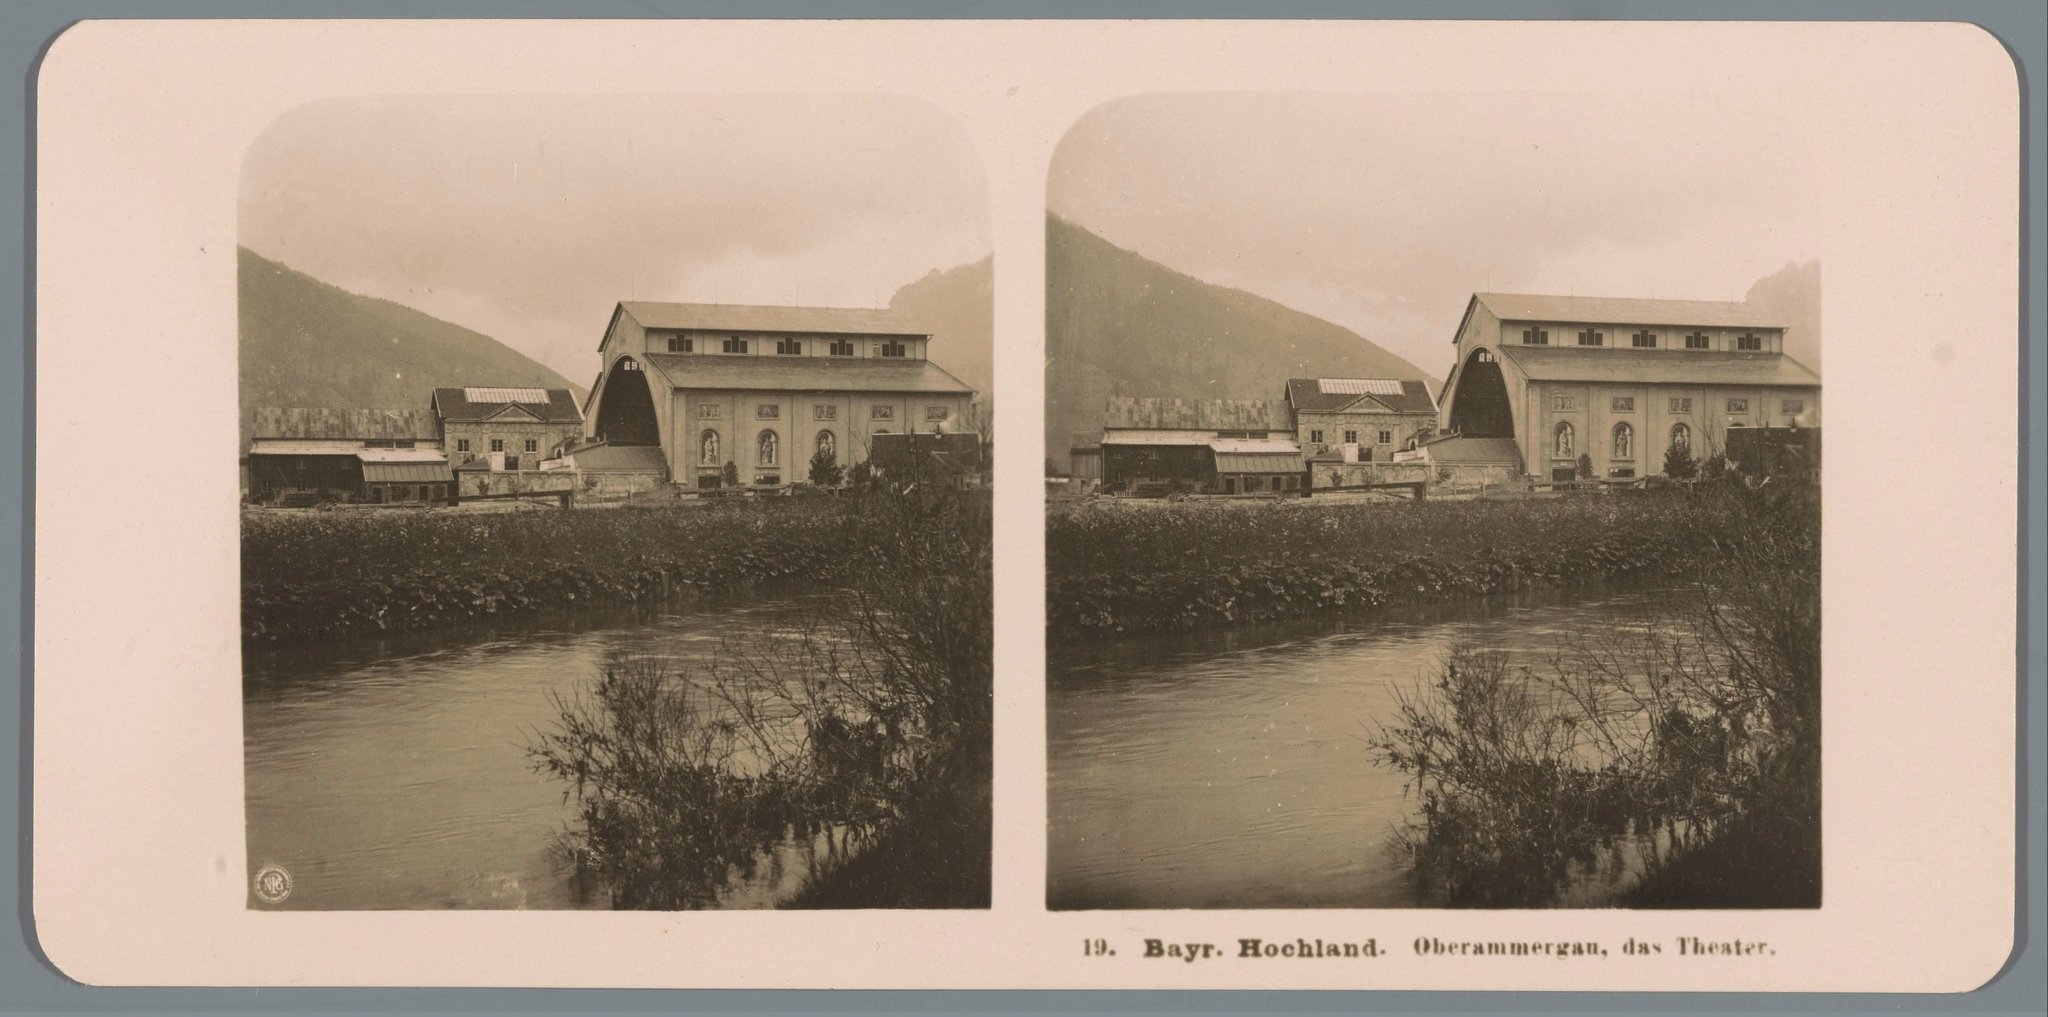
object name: stereograph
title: Gezicht op het theater van Oberammergau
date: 1900-1910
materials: cardboard, photographic support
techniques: gelatin silver print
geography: oberammergau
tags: river, theatre (building), façade (of house or building)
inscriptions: inscription: ‘NPG’, number: ‘19.’